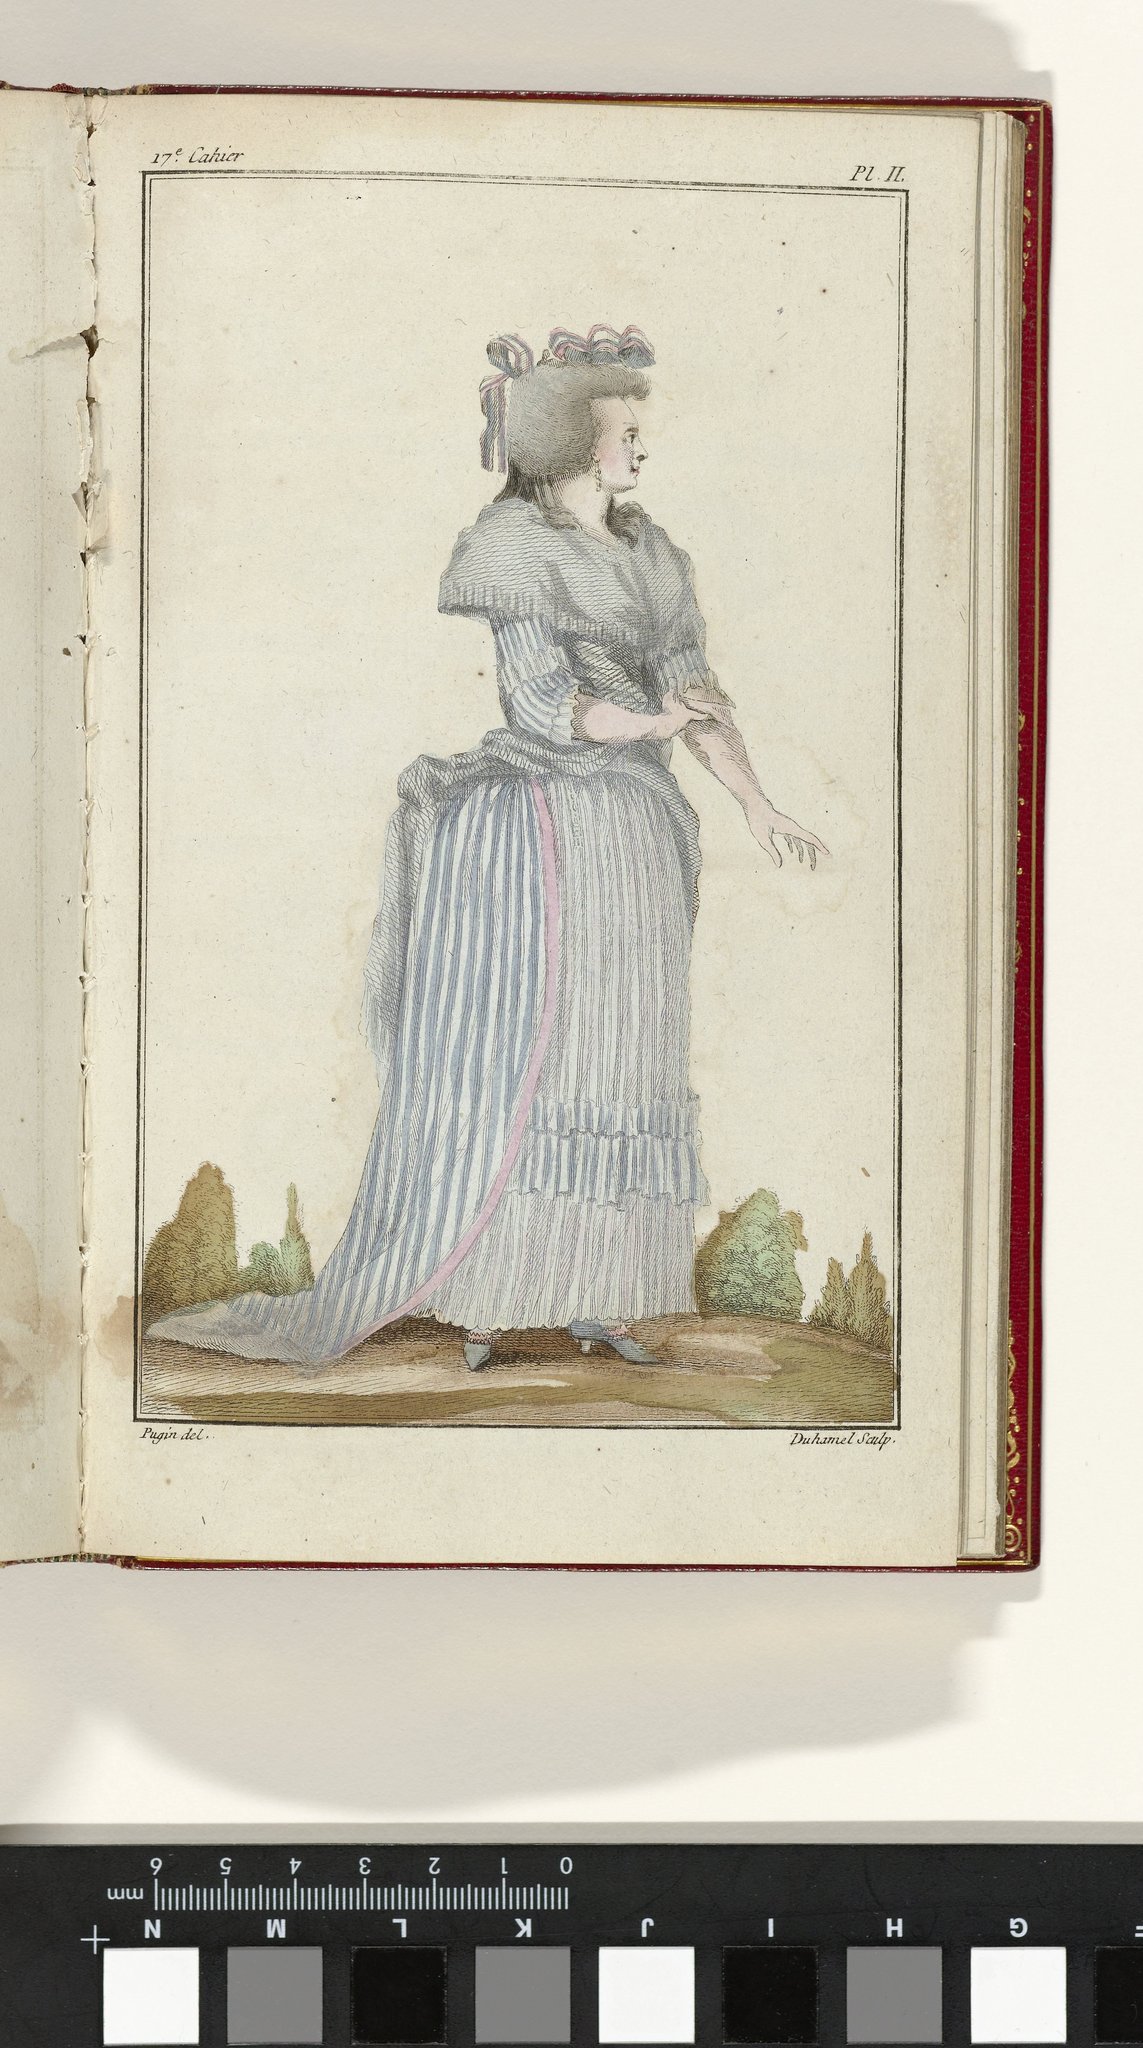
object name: fashion print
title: Cabinet des Modes ou les Modes Nouvelles, 15 Juillet 1786, pl. II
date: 1786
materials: paper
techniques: engraving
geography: paris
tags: ear-rings (+ women's clothes), gloves, mittens (long gloves) (+ women's clothes), clothing for the upper part of the body (shawl) (+ women's clothes), dress, gown (robe à la turque) (+ women's clothes), styles of hairdress - aa - ~ women, fashion plates, shoes, sandals (+ women's clothes), skirt (+ women's clothes)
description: Robe à la Turque. De vrouw is, volgens de begeleidende tekst, gekleed in een ‘robe à la Turque’ van witte gaze met wit glanzende en zachtlila strepen, afgezet met zachtroze lint. Sjaal van wit geruite gaze met een franje van witte zijde, van voren gekruist en op de rug onder de ceintuur geknoopt. Kapsel met twee strikken van gestreept lint, zonder hoofddeksel. Lila schoenen met hakken en een strook van roze lint (Accessoires: oorbel, lange handschoenen, chatelaine). De prent maakt deel uit van het 17e Cahier uit de serie Cabinet des Modes ou les Modes Nouvelles. De serie bestaat uit 72 modeprenten, uitgegeven door Buisson, Parijs, 15 november 1785 - 1 november 1786.